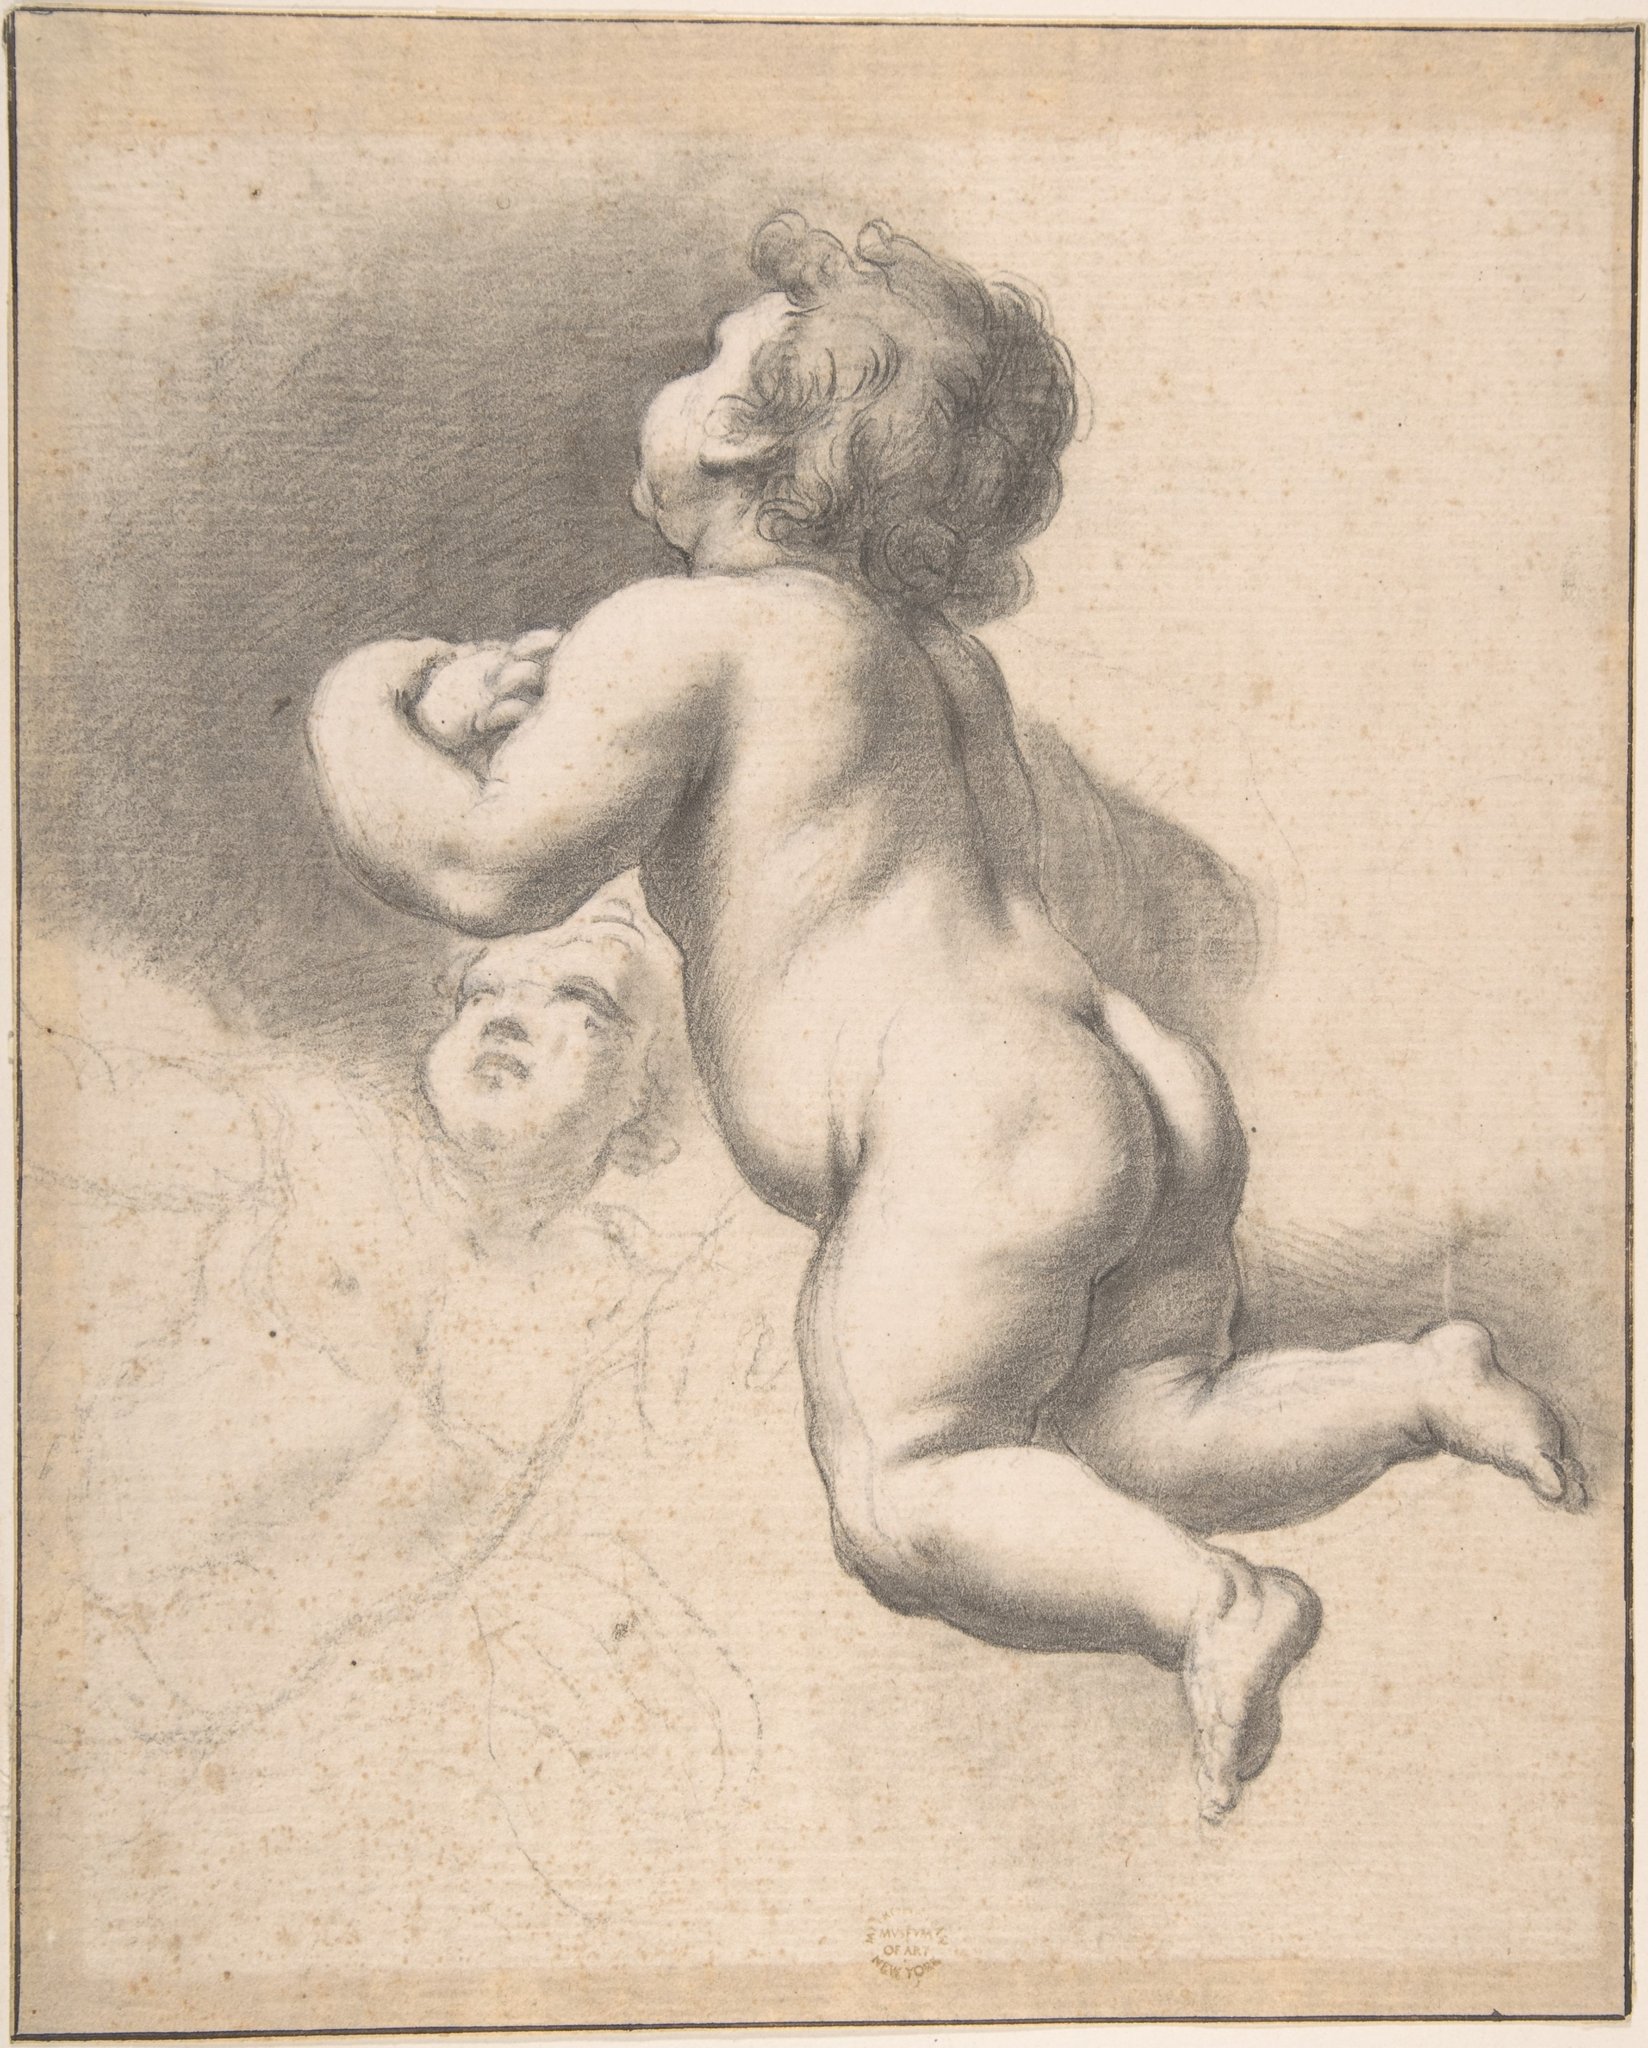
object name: drawing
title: Cherubs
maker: anonymous, italian, roman-bolognese, 17th century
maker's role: artist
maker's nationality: italian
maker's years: 1600-1700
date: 1601-1700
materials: chalk, ink, paper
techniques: highlighting, pen, stumping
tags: infants